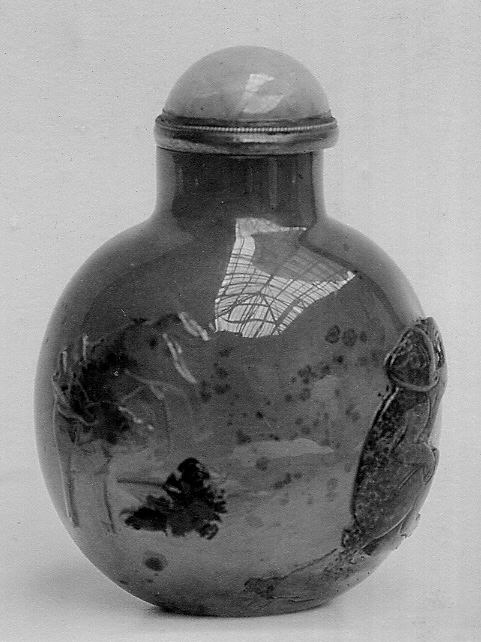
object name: snuff bottle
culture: chinese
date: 1801-1900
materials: stone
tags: deer,monkeys